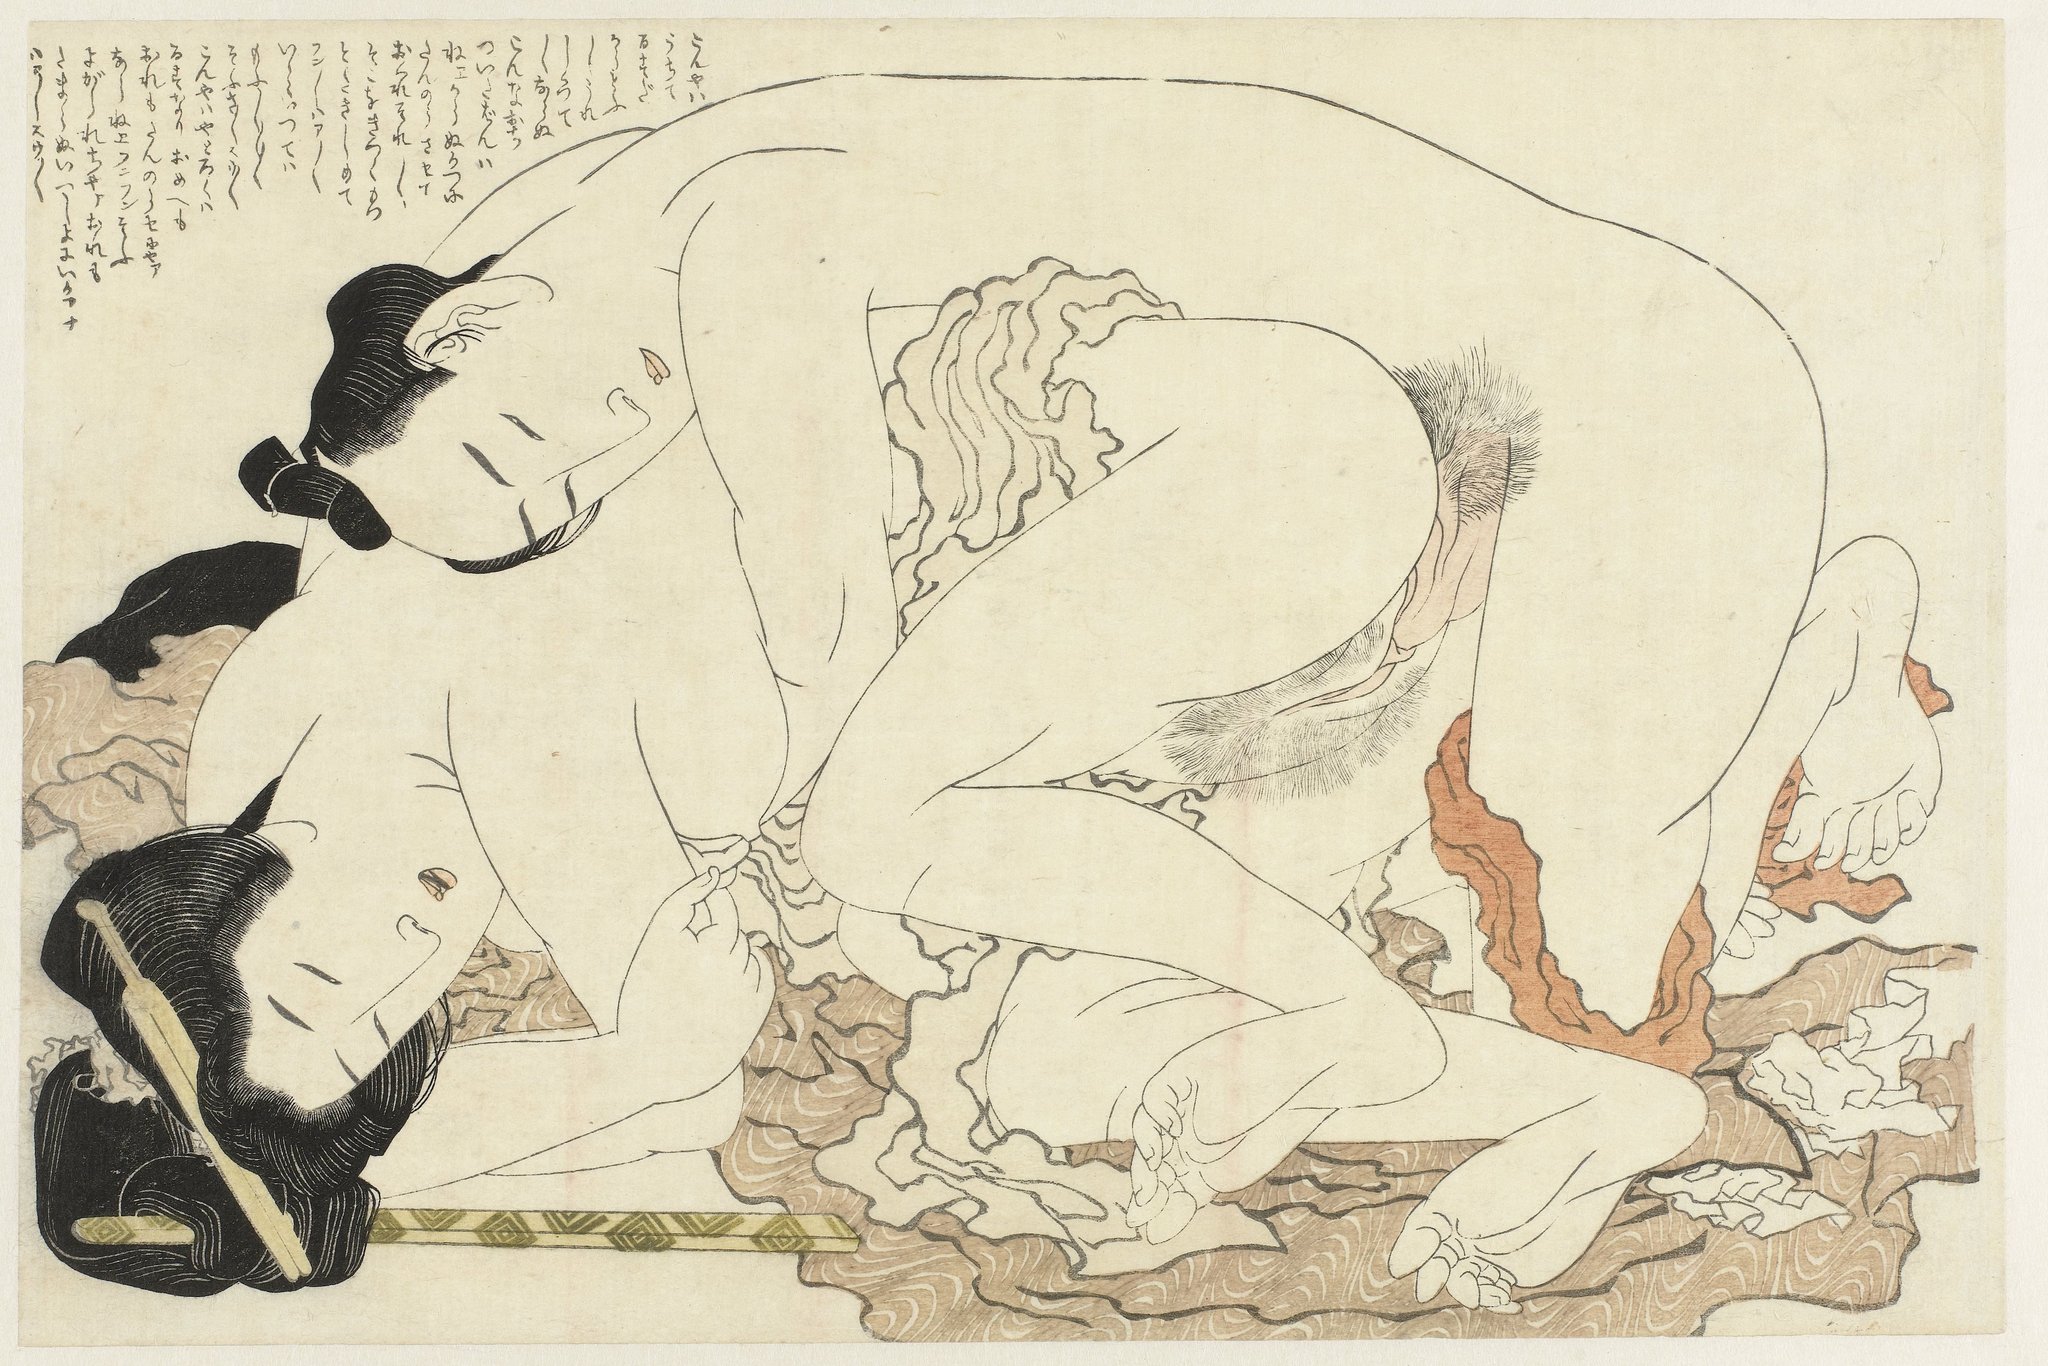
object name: print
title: De Adonis plant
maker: katsushika hokusai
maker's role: draughtsman, print maker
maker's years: 1760-1849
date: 1815-1823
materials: paper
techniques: blind stamped, woodcut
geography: japan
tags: man and woman cohabiting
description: Getrouwde vrouw, herkenbaar aan de zwarte tanden, de liefde bedrijvend met minaar; verfrommelde tissues op de voorgrond rechtsonder.